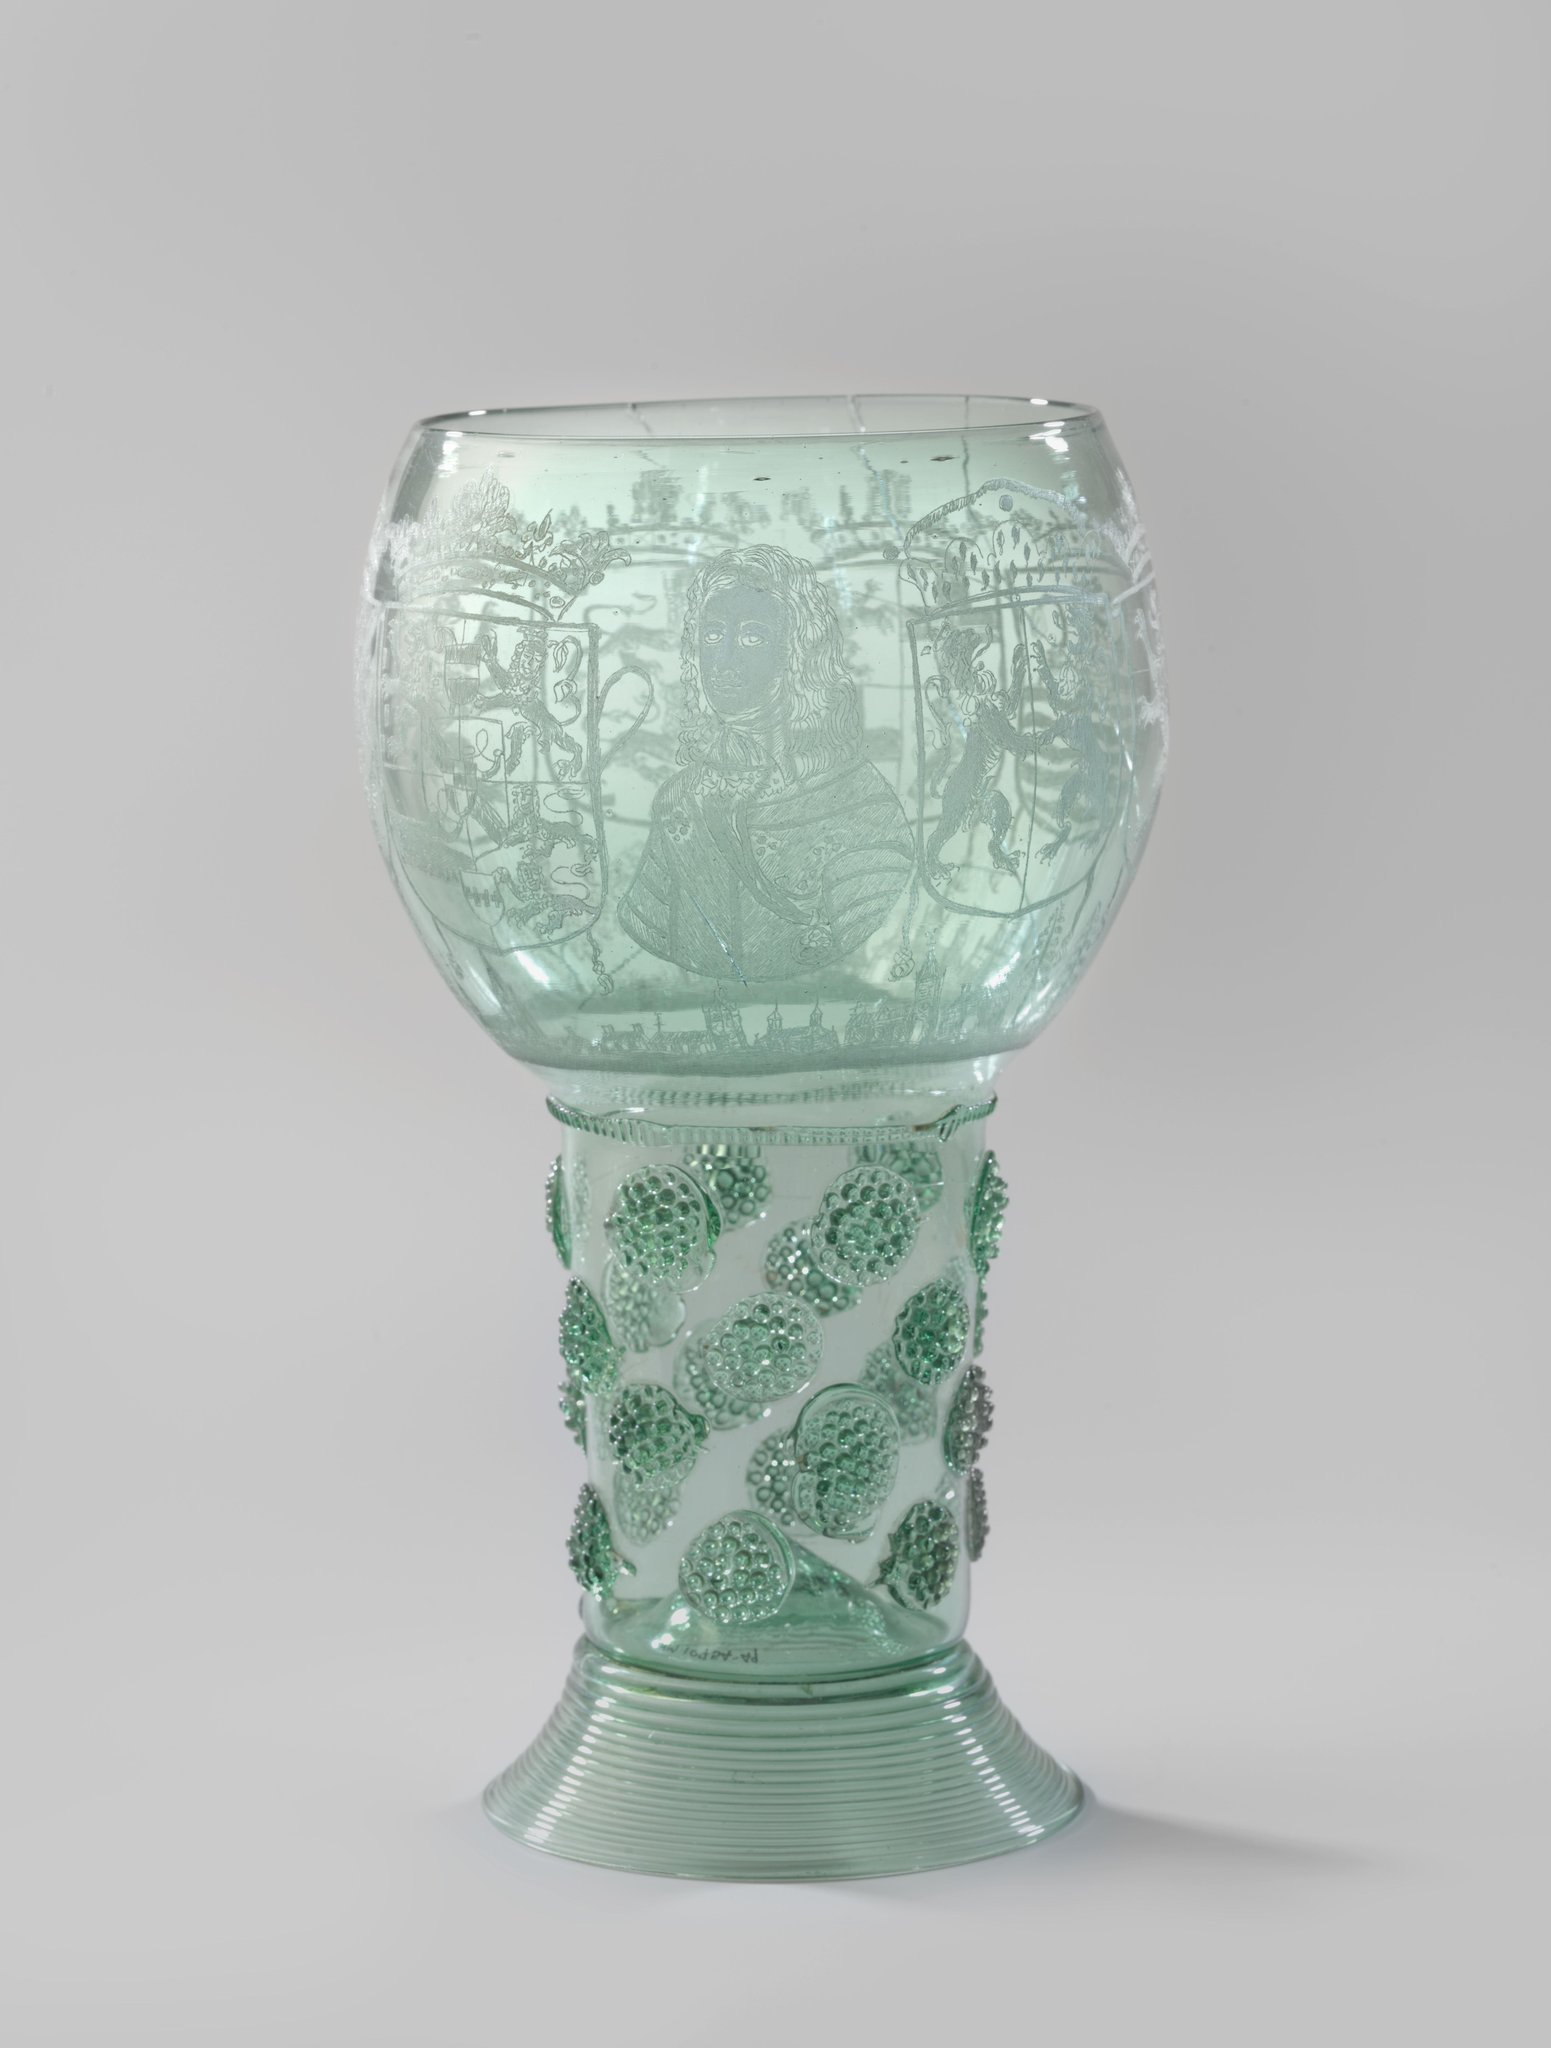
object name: roemer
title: Roemer met een portret van Willem III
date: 1665-1680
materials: glass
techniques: diamond point engraving, glassblowing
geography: northern netherlands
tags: the hague, william iii (prince of orange and king of england, scotland, and ireland)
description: Orange souvenirs. William III's popularity, and later also that of his wife Mary, gave rise to a wide variety of objects sporting their pictures: medallions, glasses, tiles, cutlery and Delftware pottery.